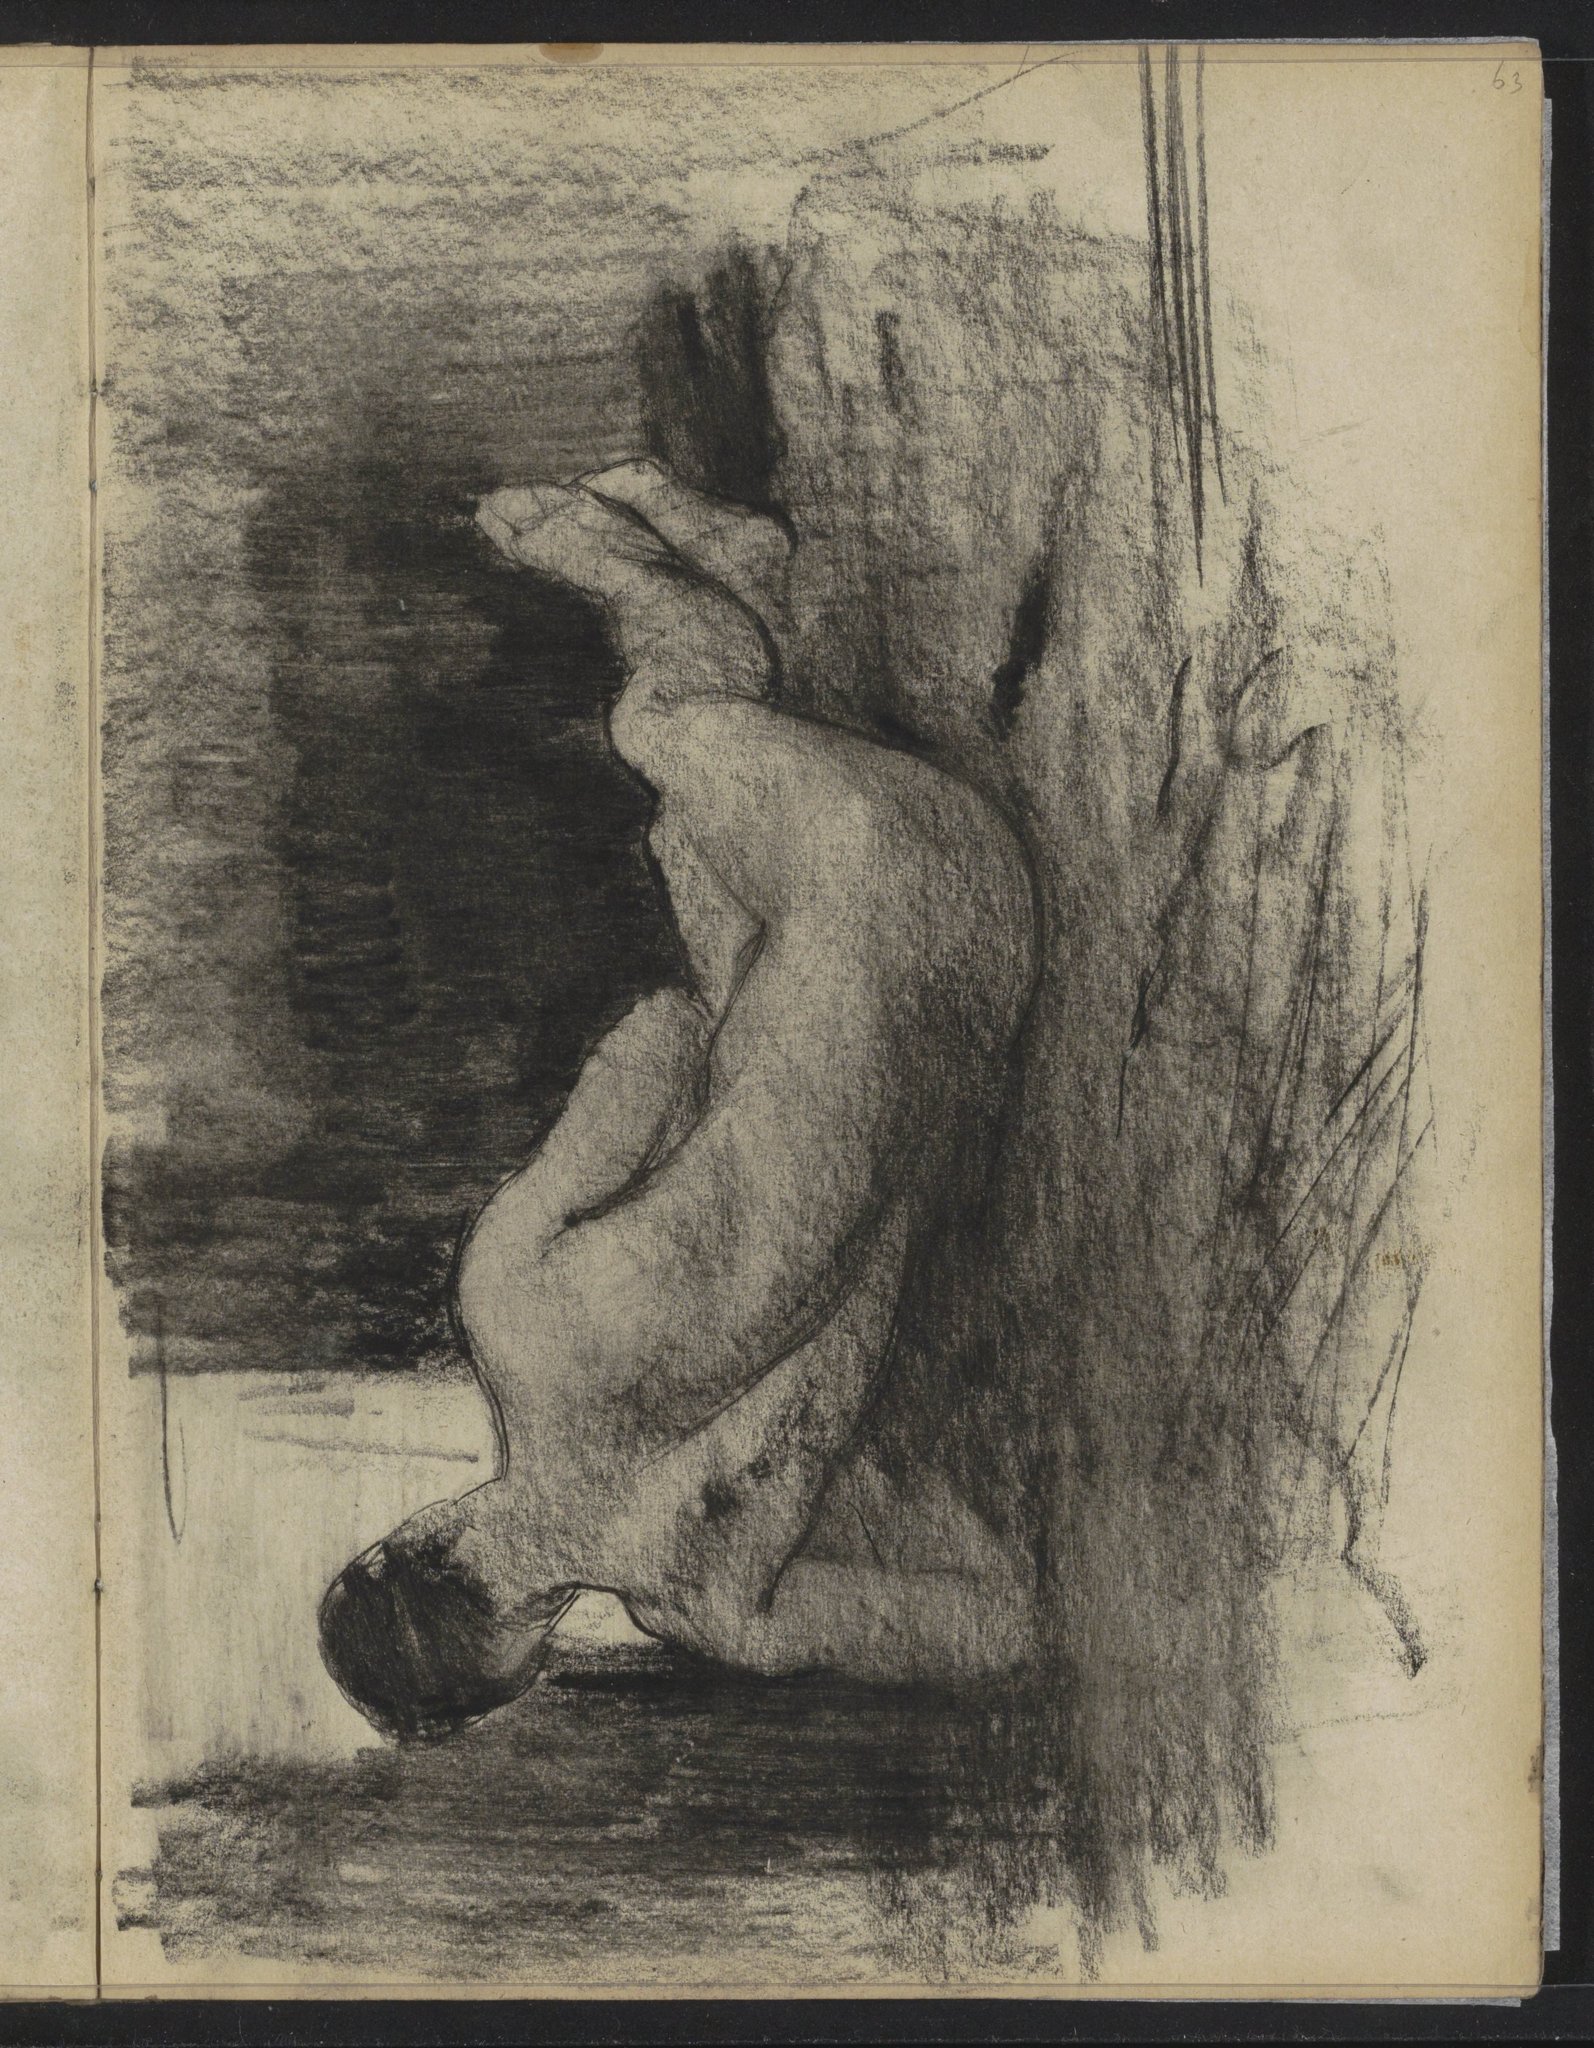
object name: sketchbook leaf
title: Liggend vrouwelijk naakt in een interieur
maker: willem witsen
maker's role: draughtsman, painter, print maker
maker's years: 1860-1923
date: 1886-1891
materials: chalk, paper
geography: london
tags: the (nude) human figure; 'corpo humano' (ripa) - aa - female human figure (+ lying), interior of the house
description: Ze steunt op een elleboog. Pagina 63 uit een schetsboek met 40 bladen.